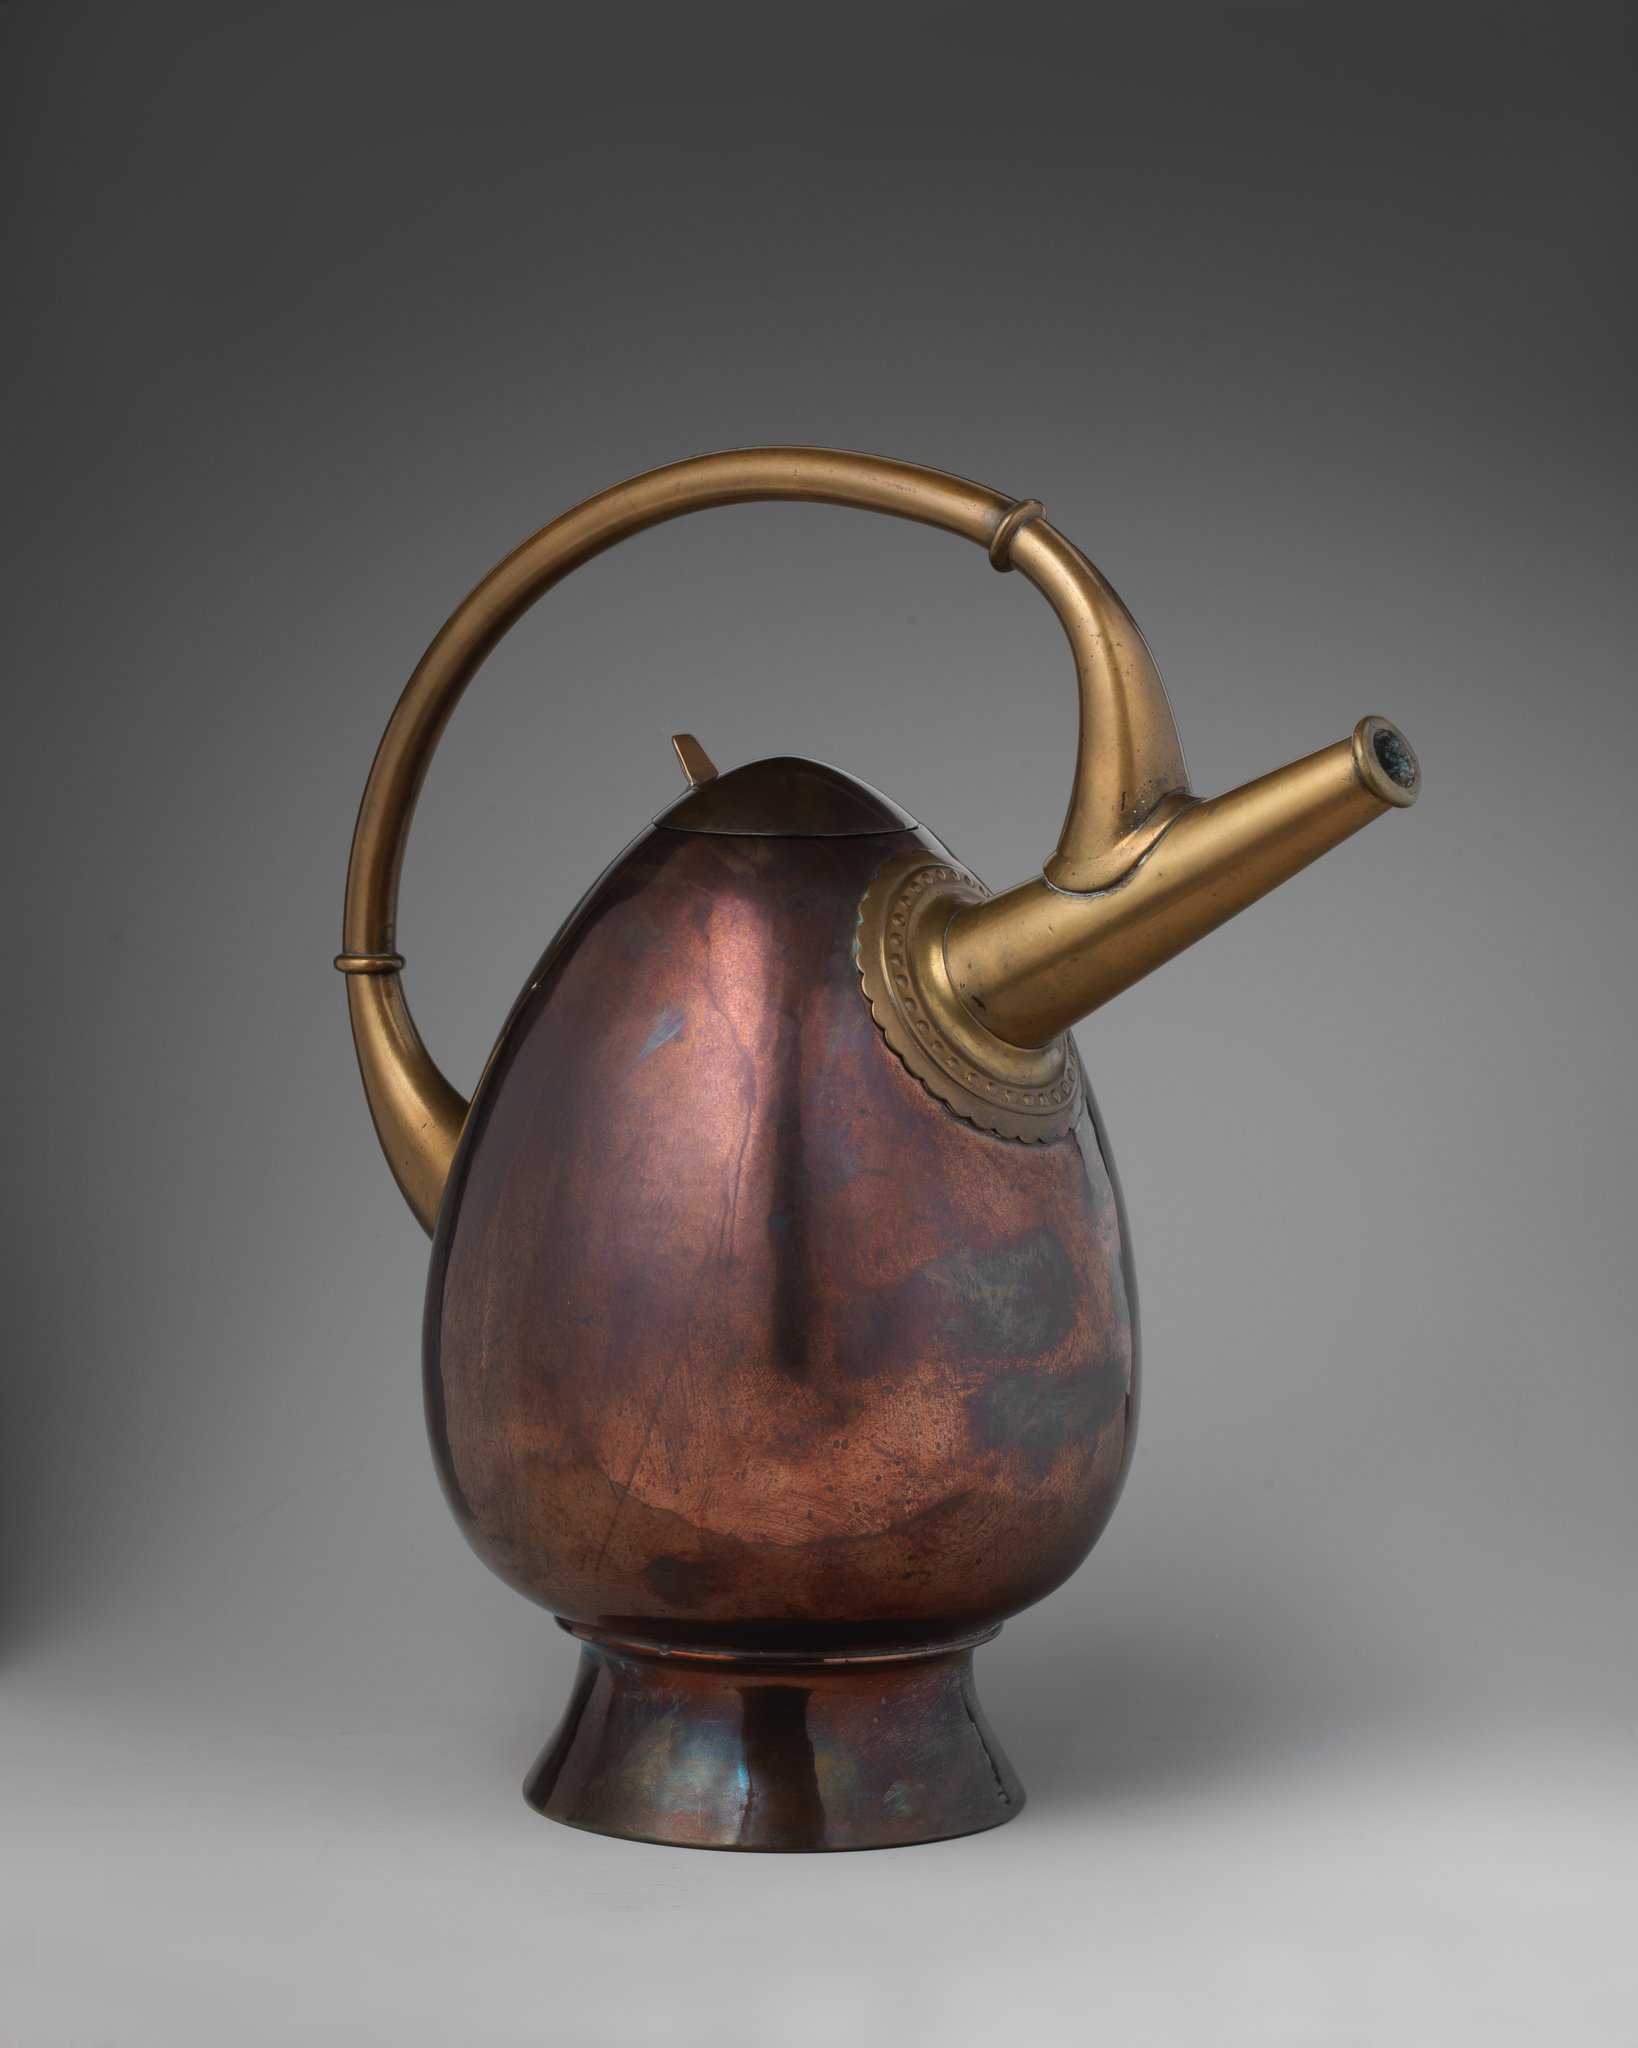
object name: kettle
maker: christopher dresser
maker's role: designer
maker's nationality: british, scottish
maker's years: 1834-1904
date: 1885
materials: brass, copper